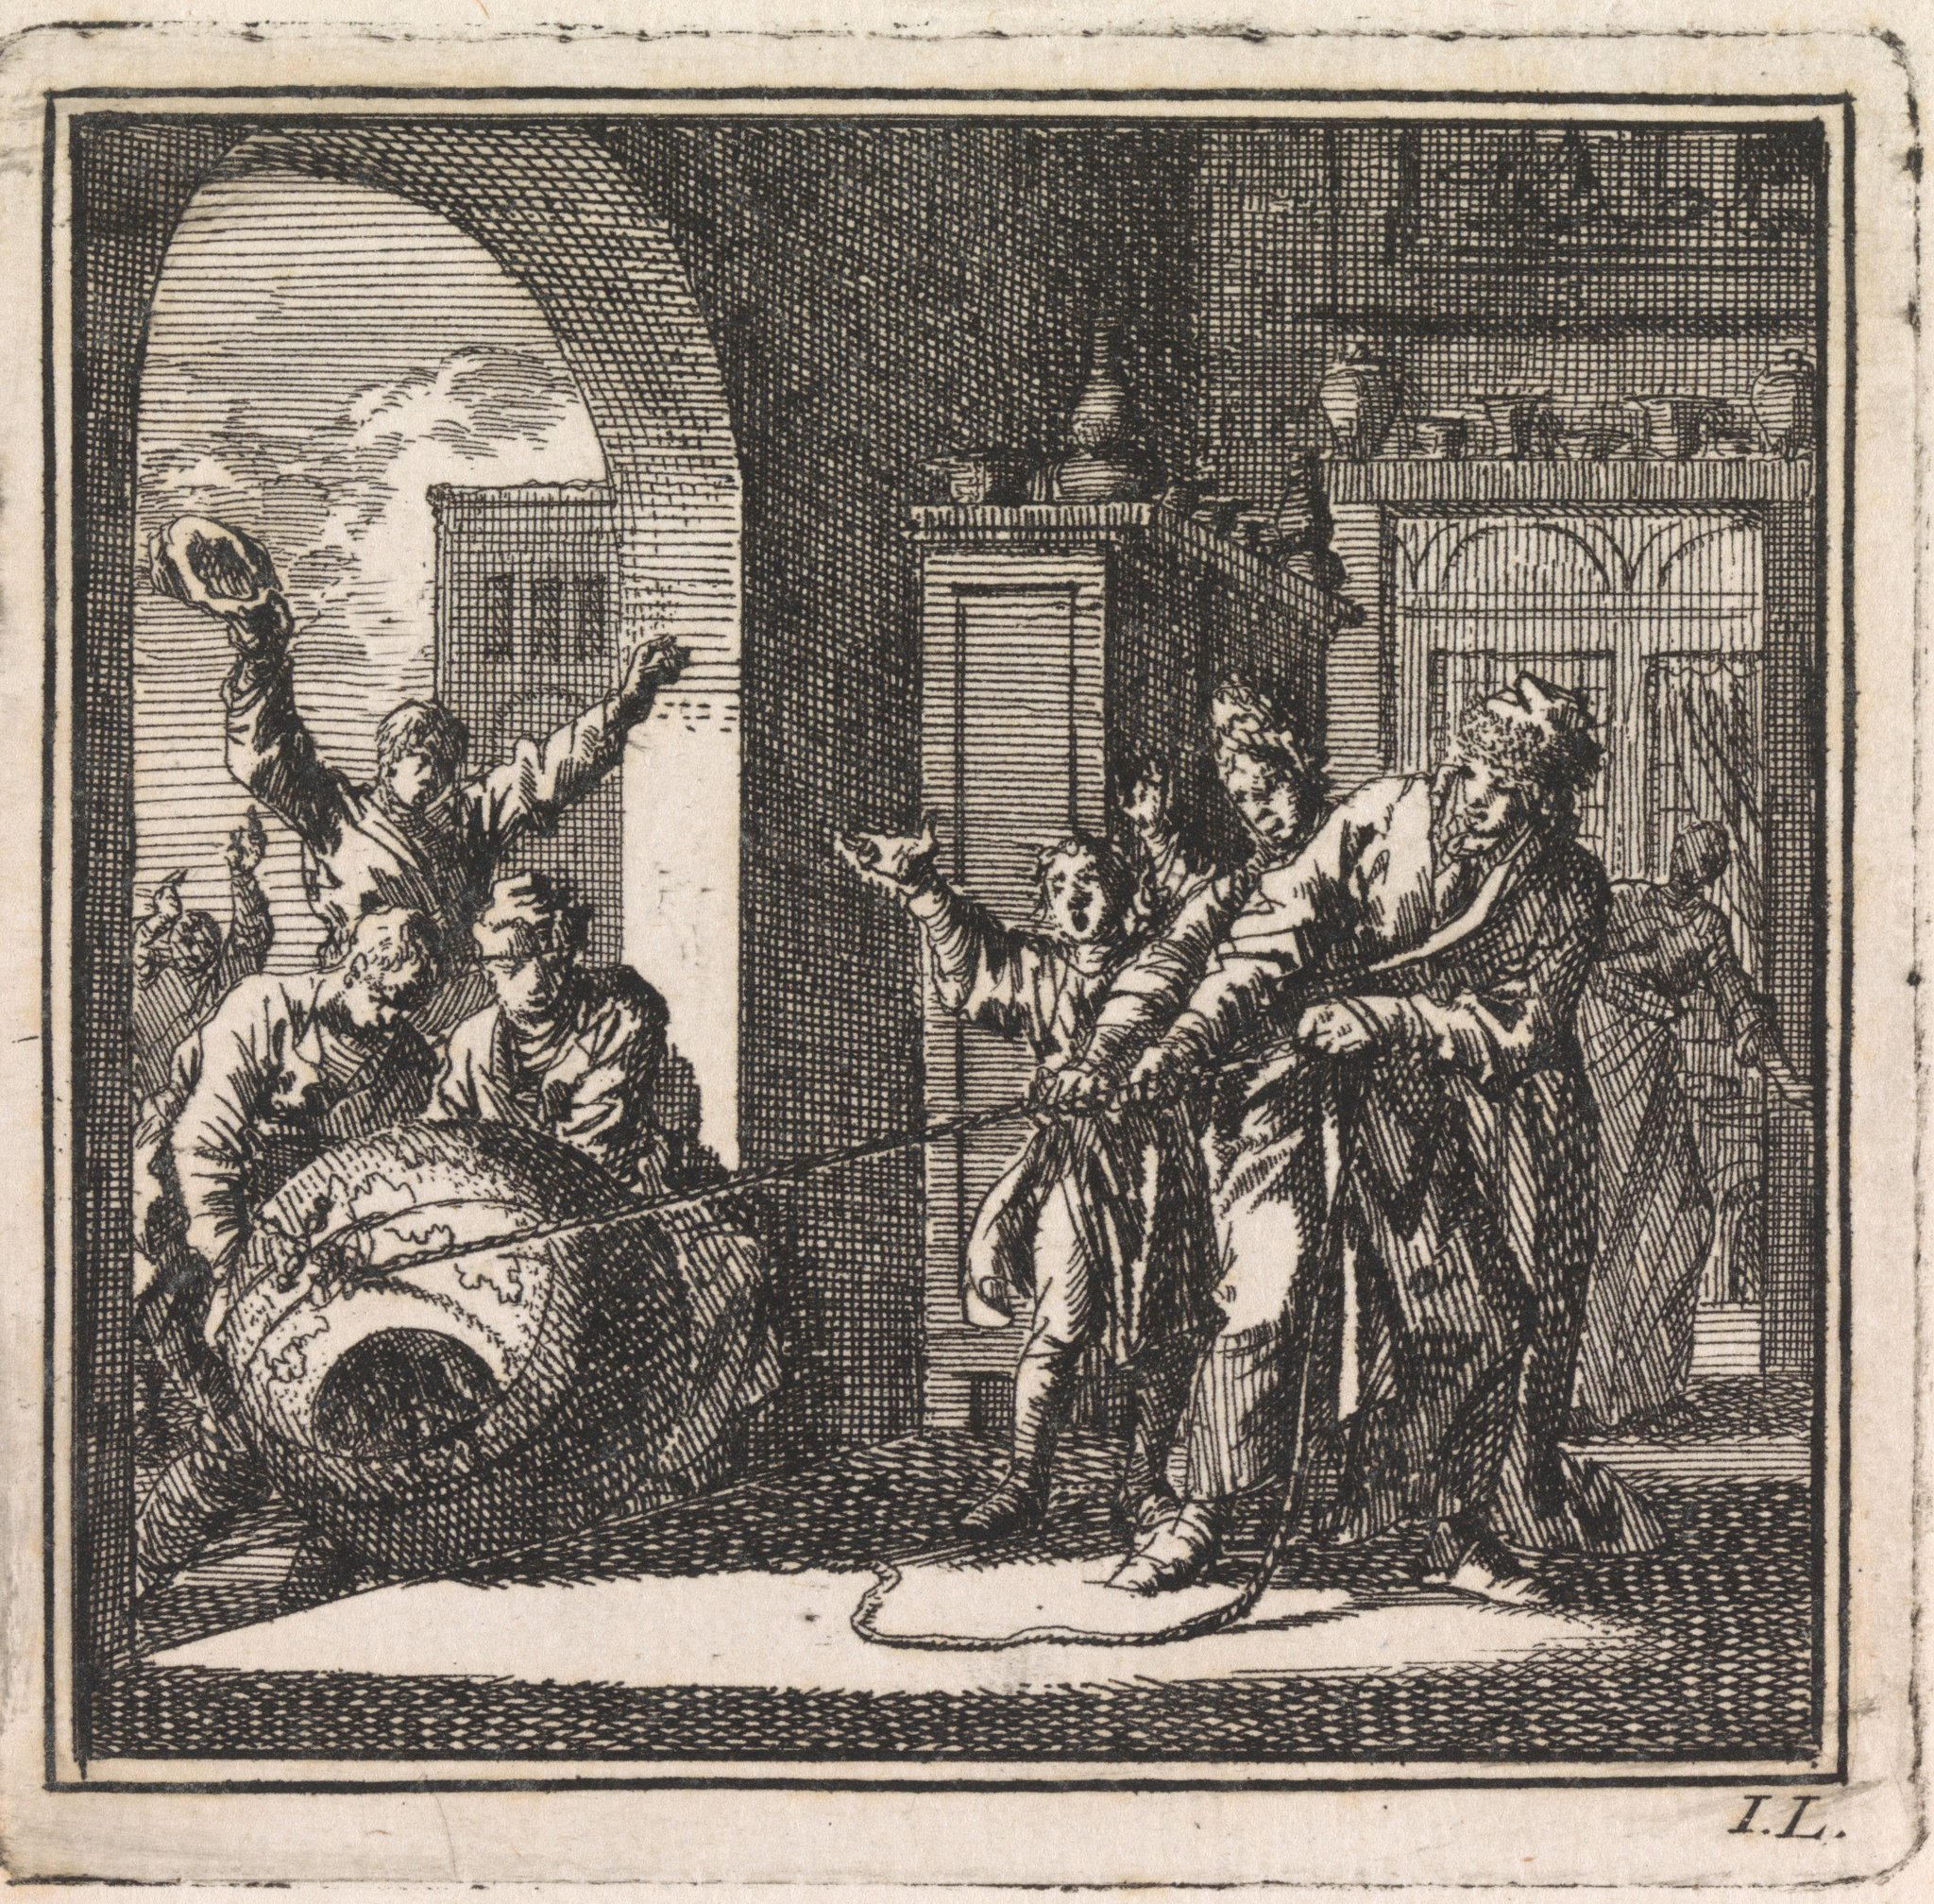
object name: book illustration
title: De Schadelyke Moeite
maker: jan luyken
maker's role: draughtsman, print maker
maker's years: 1649-1712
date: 1710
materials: paper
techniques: etching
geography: amsterdam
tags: earth, world as celestial body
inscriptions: collector's mark: Lugt 2228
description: Illustratie uit: Luyken, Jan. De onwaardige wereld, vertoond in vyftig zinnebeelden, met godlyke spreuken en stichtelyke verzen. Amsterdam: Pieter Arentsz. II (wed.) en Cornelis van der Sys, 1710, p. 82.